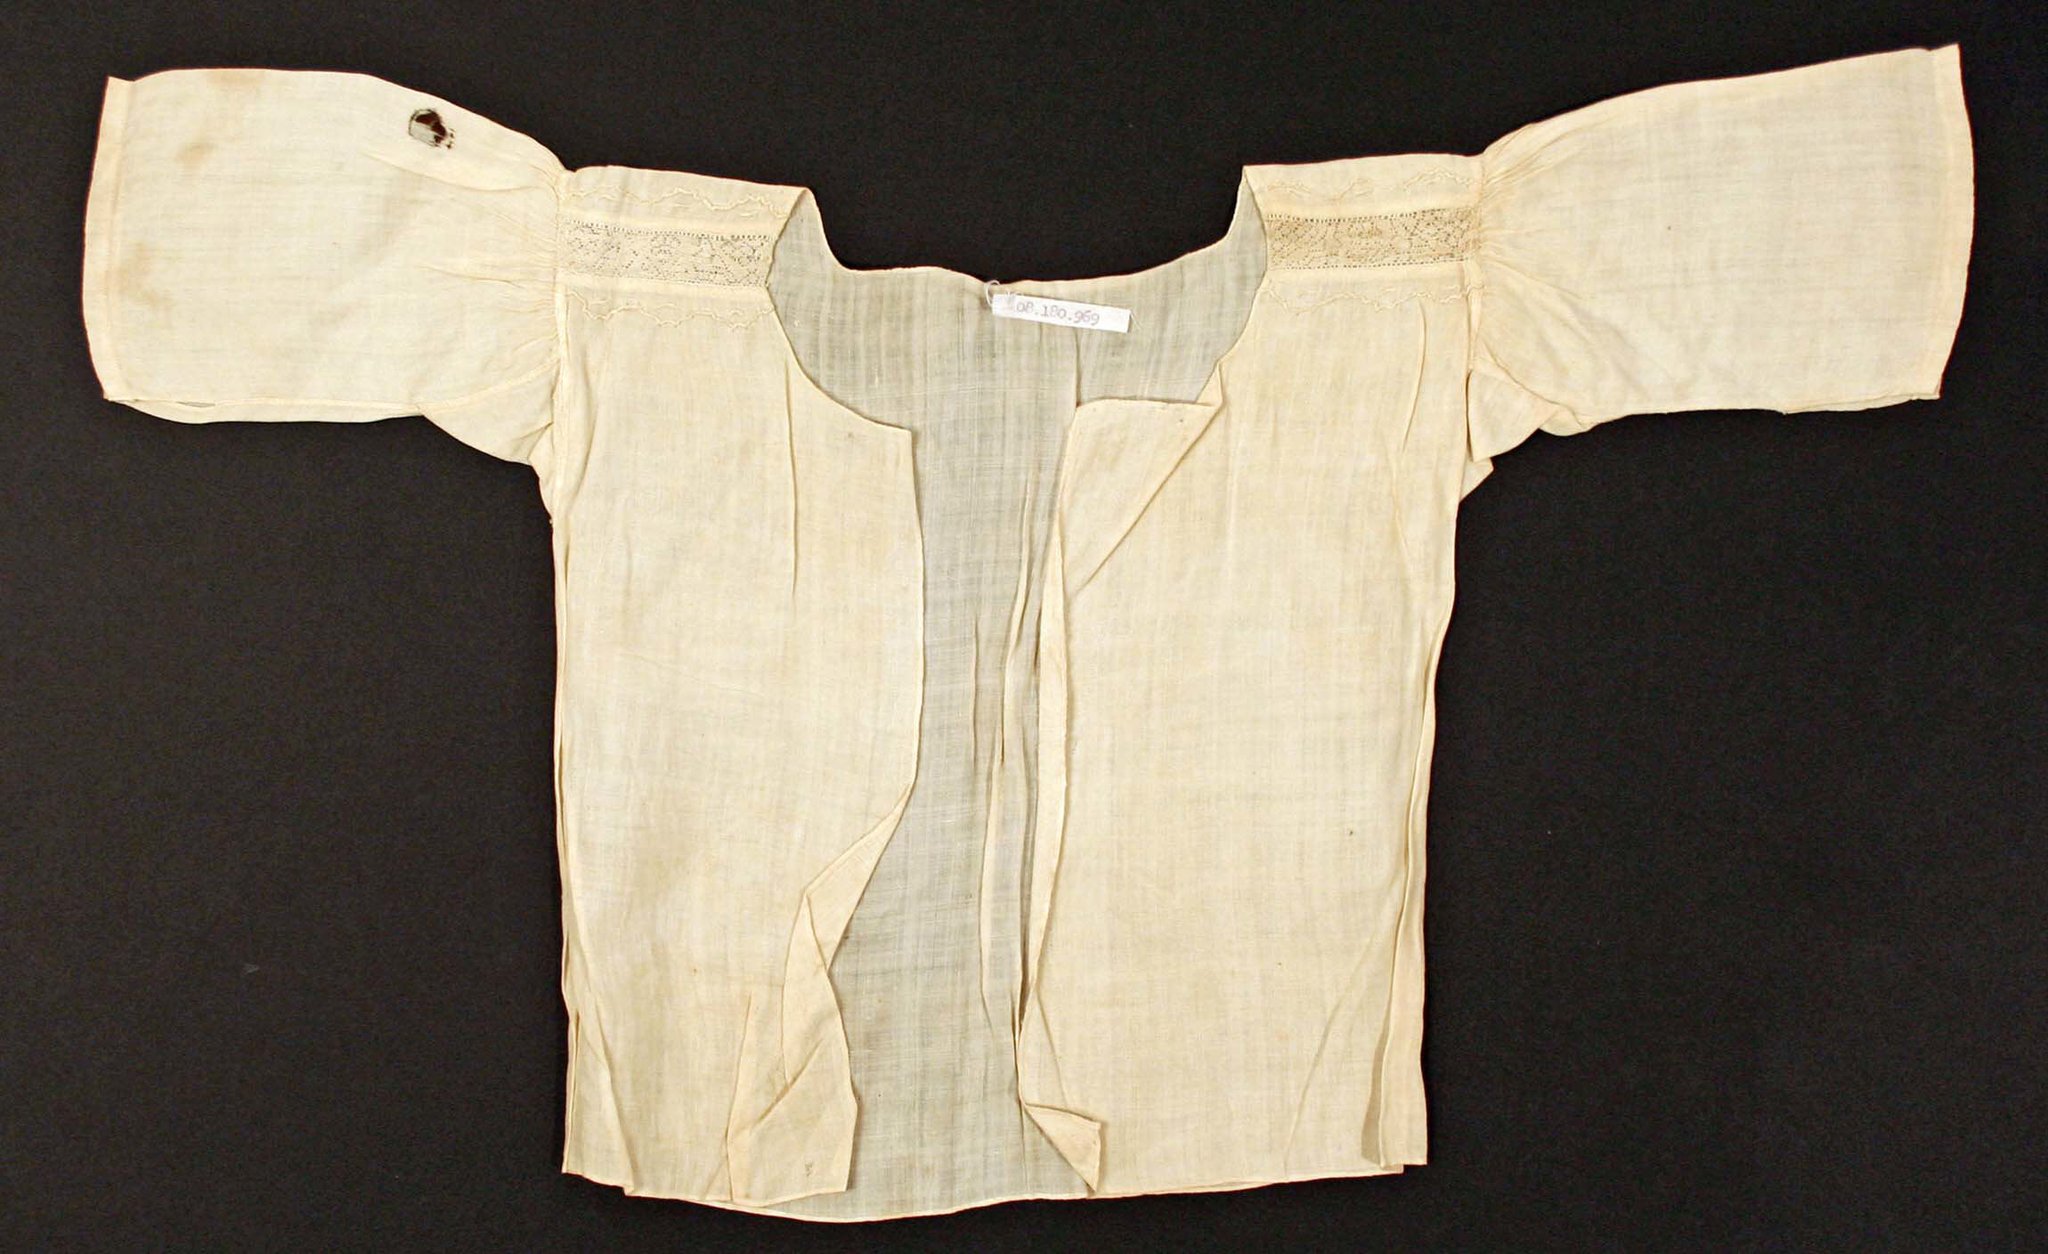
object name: shirt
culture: british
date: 1701-1800